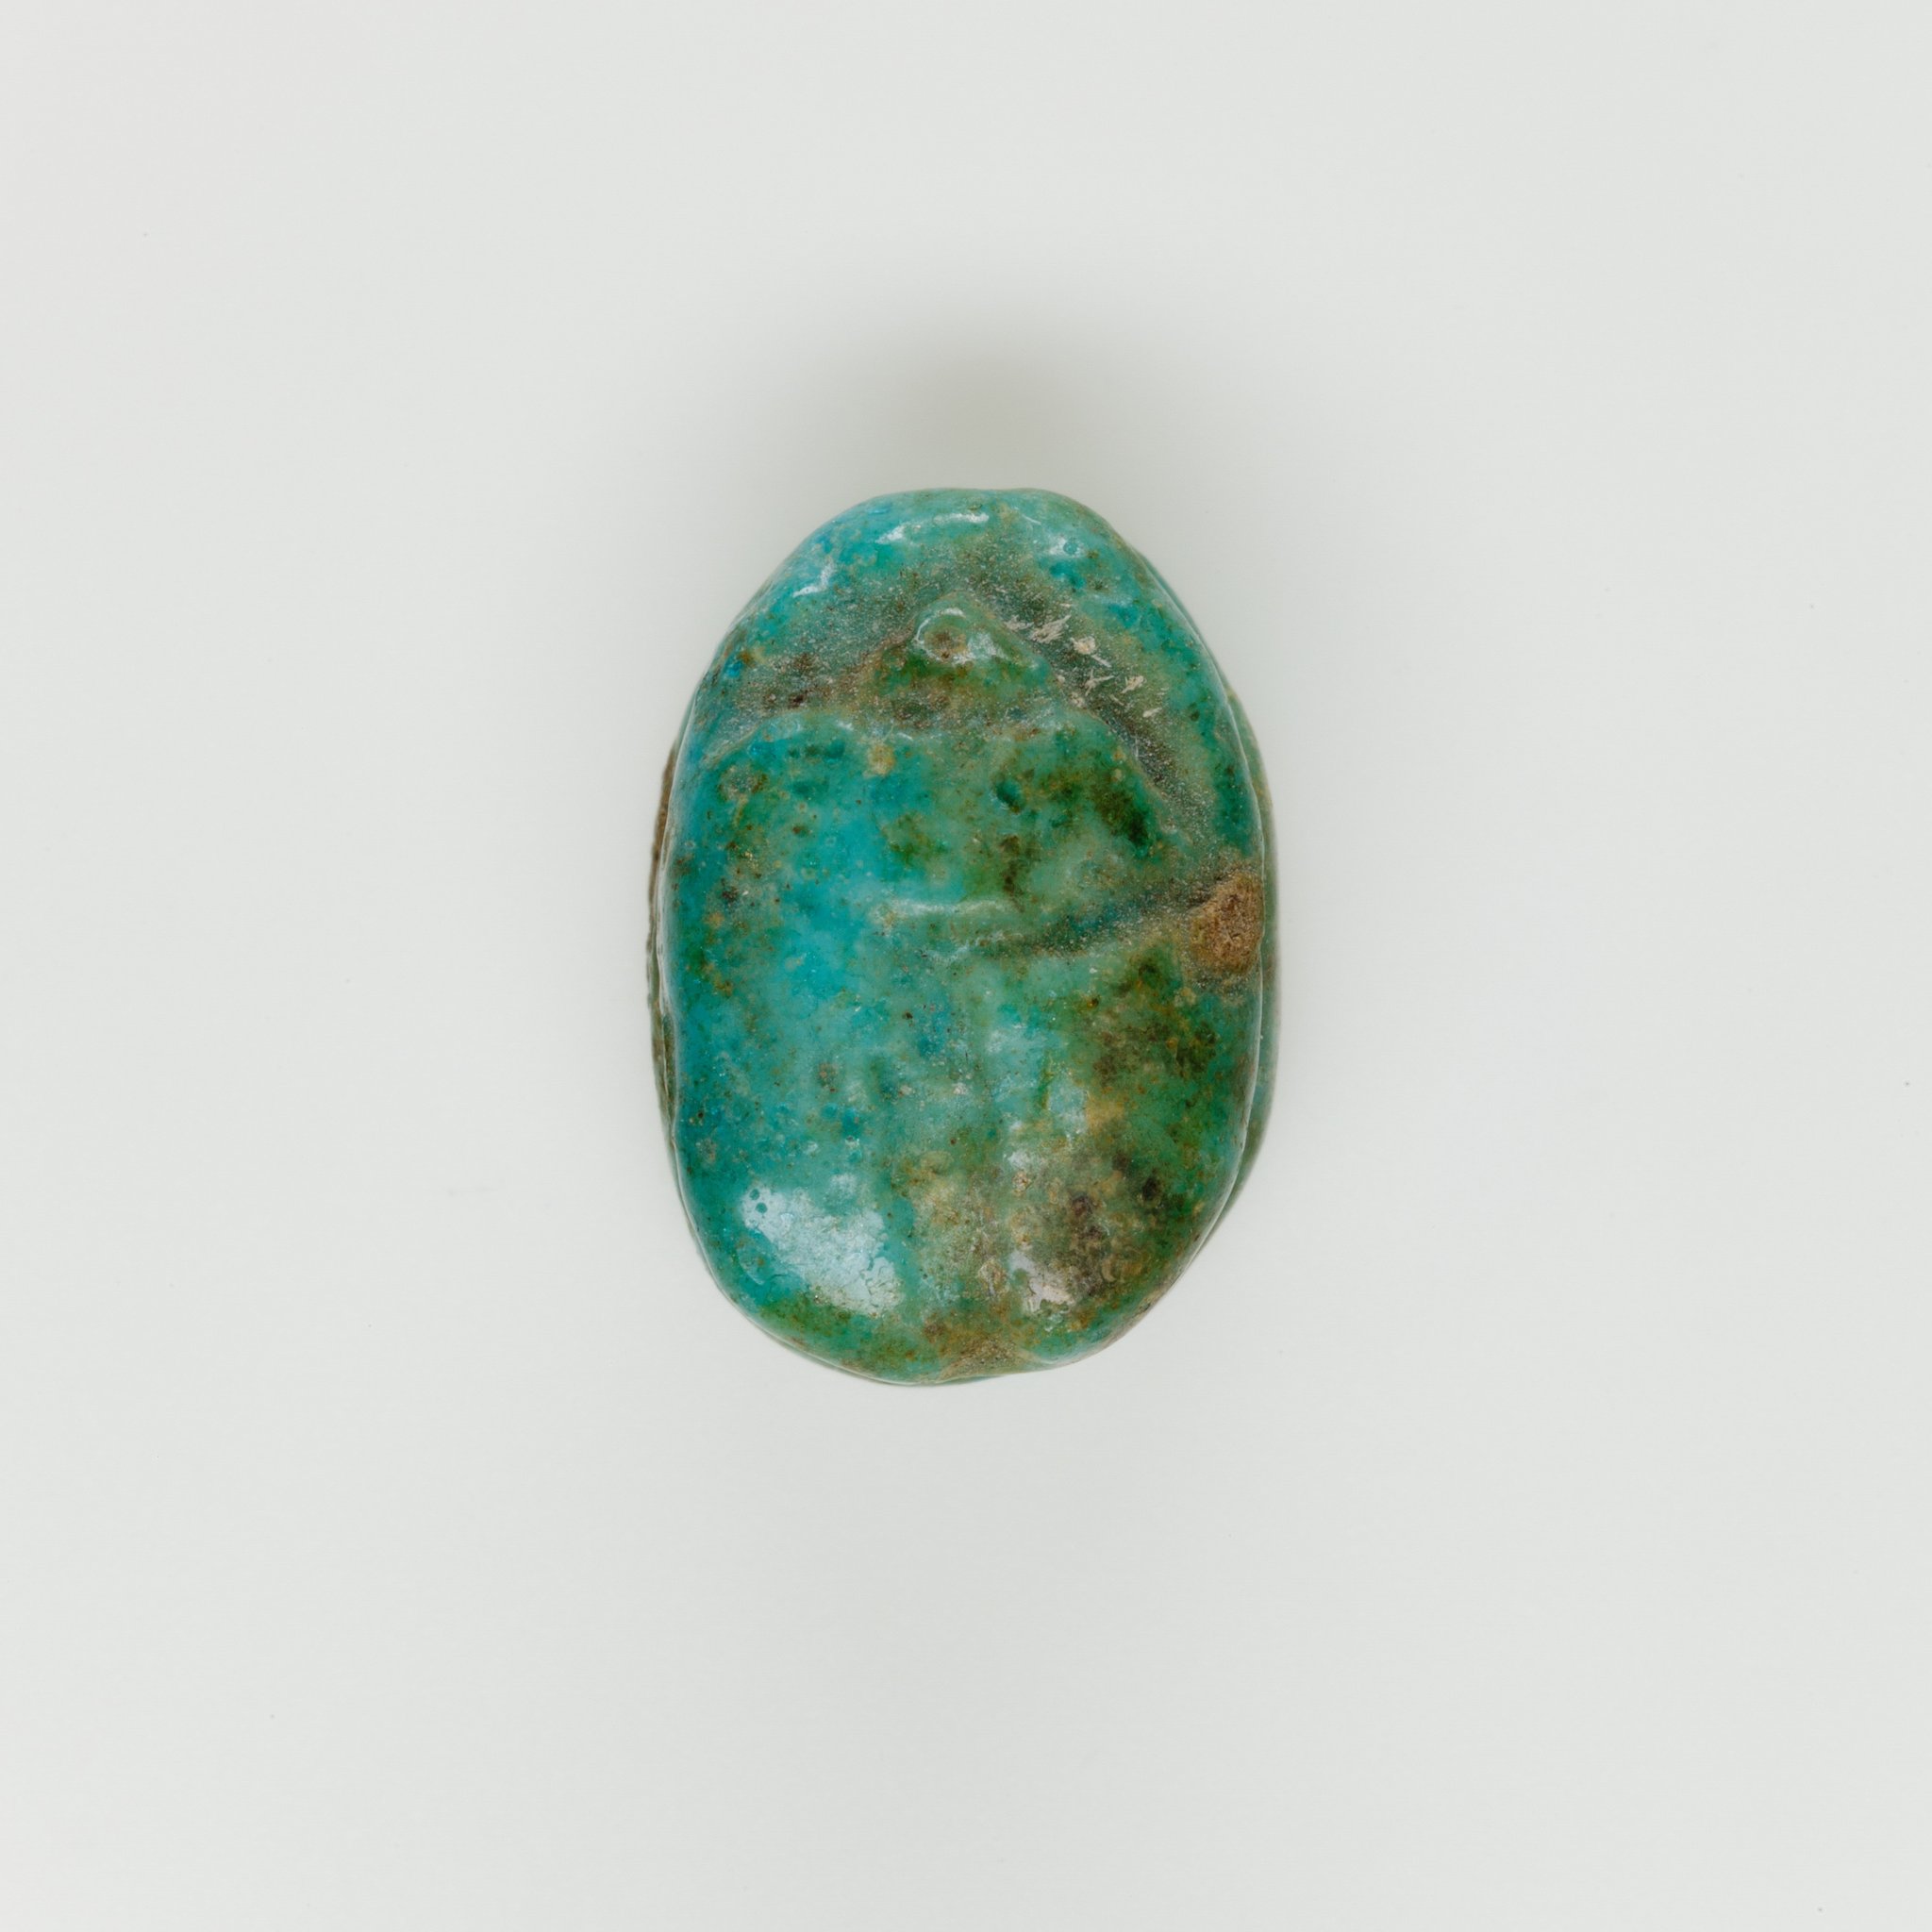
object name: bead, scarab, amenemhat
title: Uninscribed Scarab Bead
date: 1504-1447 BCE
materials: faience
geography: egypt